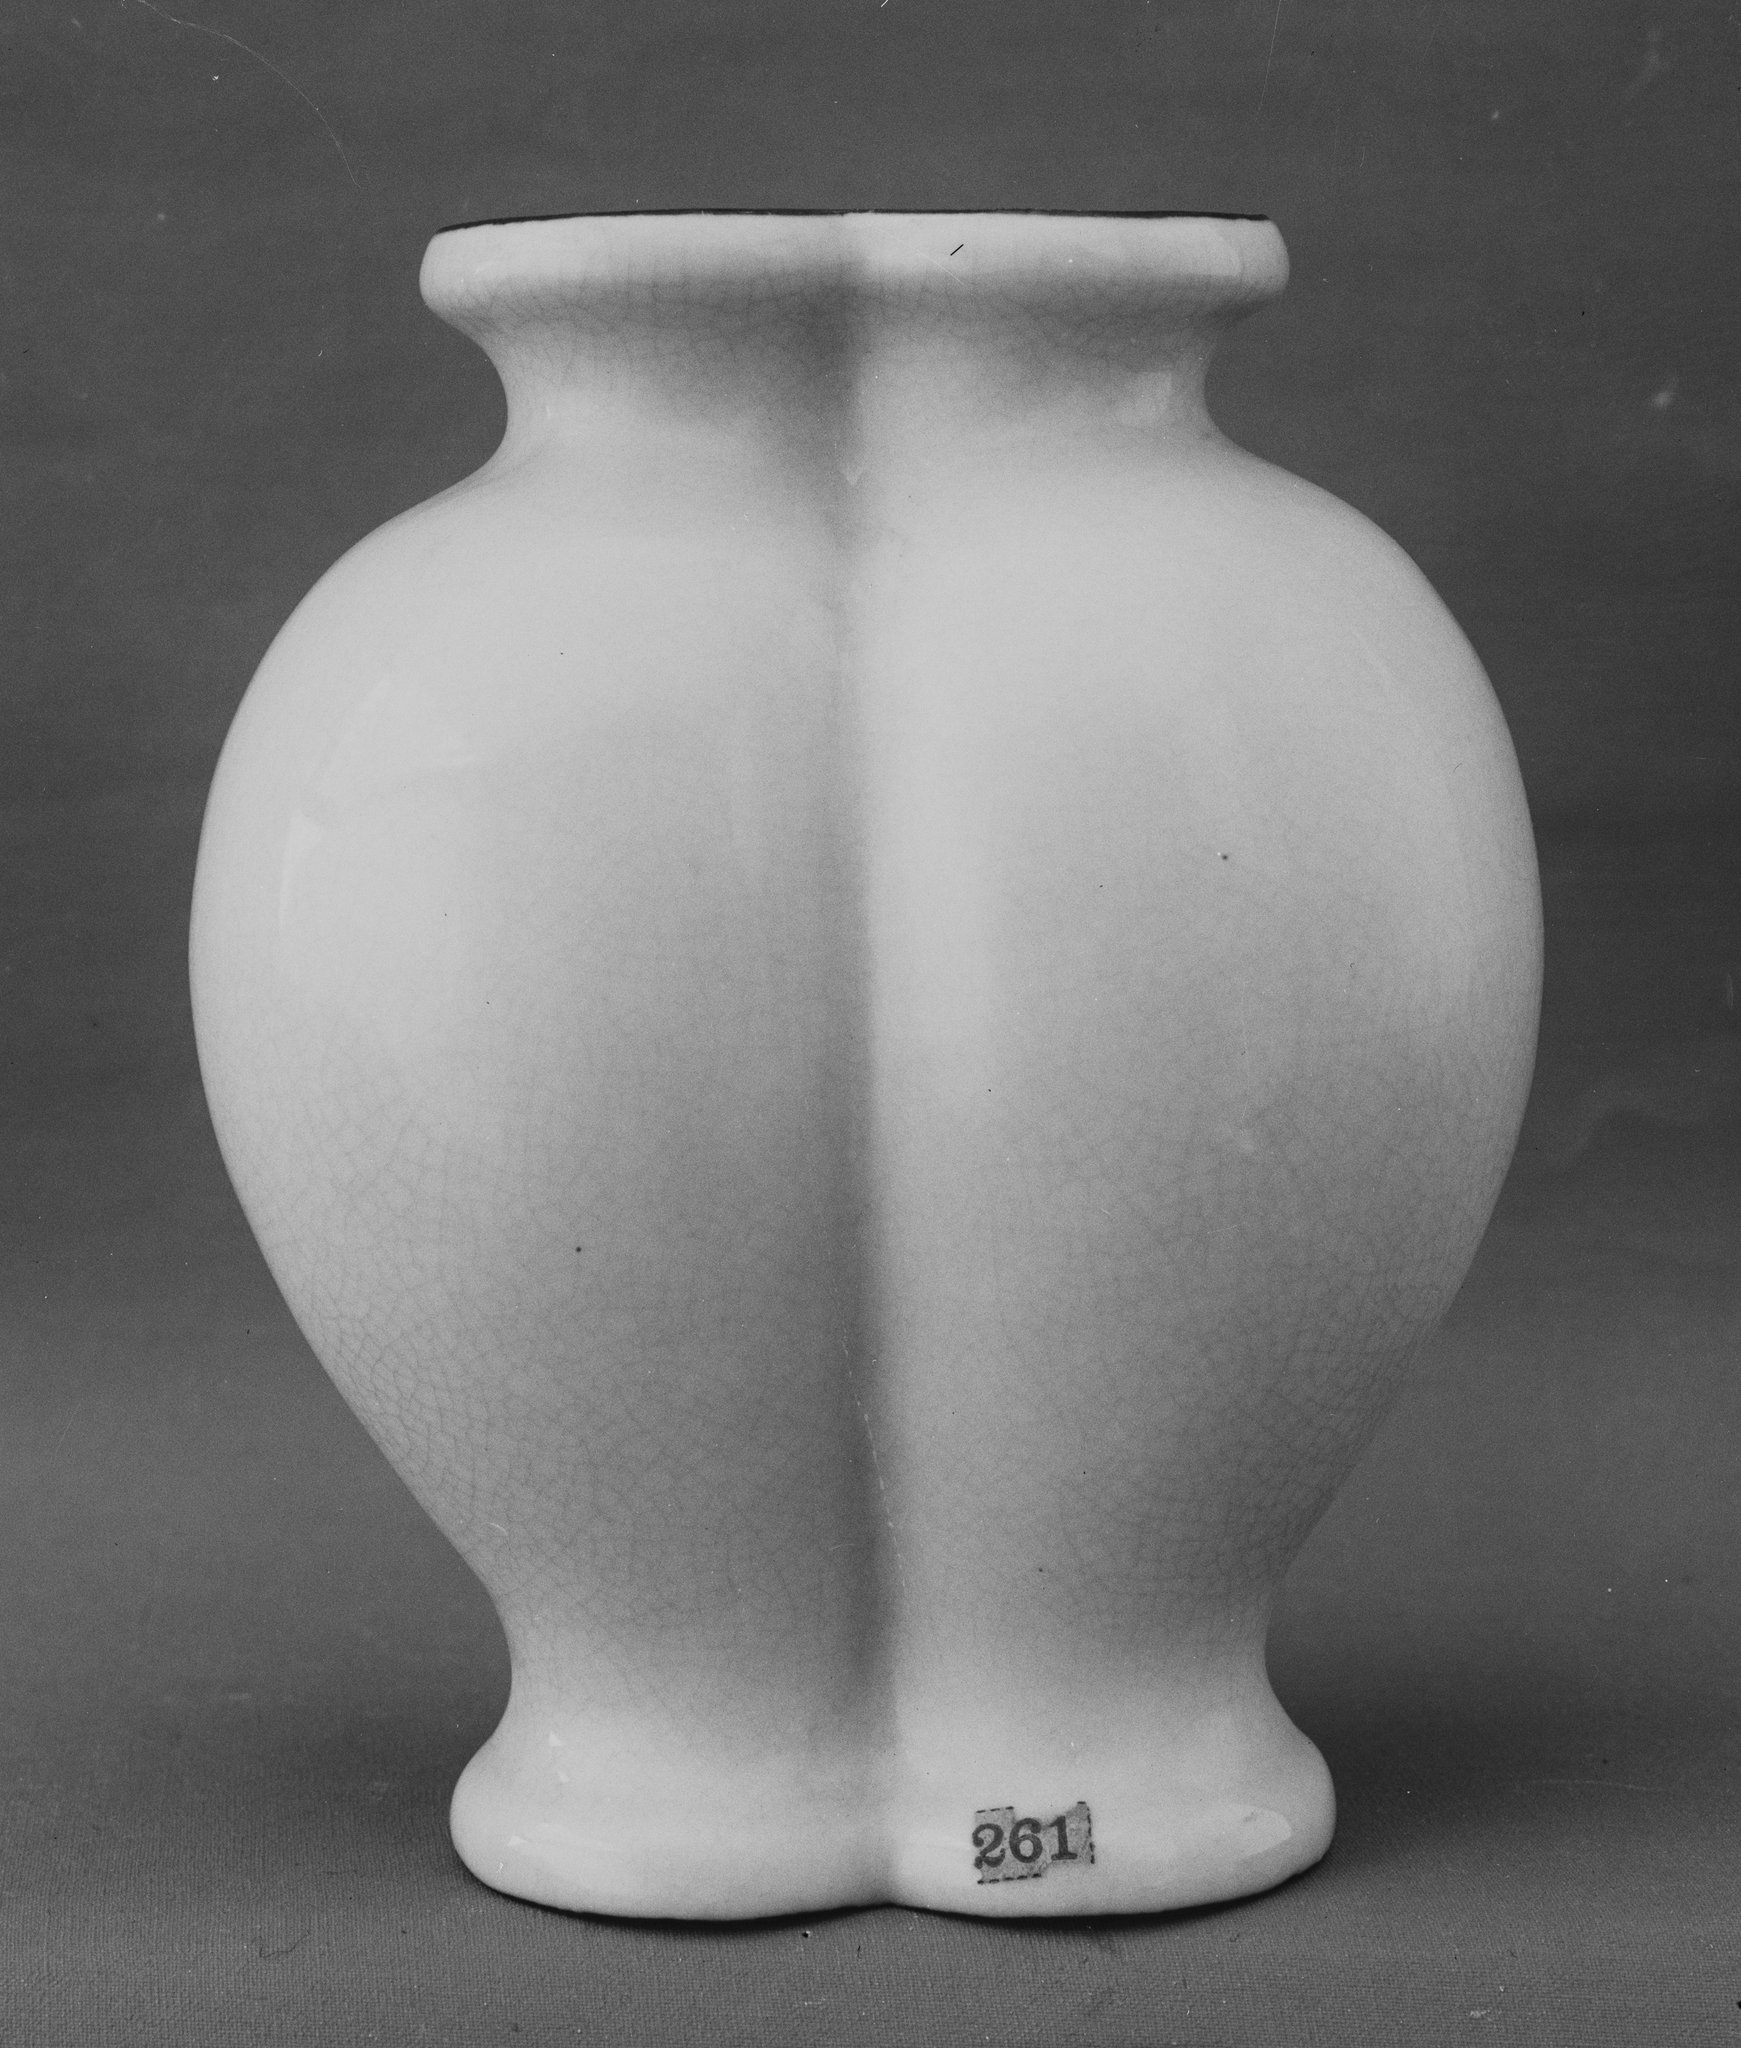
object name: double vase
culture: chinese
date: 1736-1795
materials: glaze, porcelain